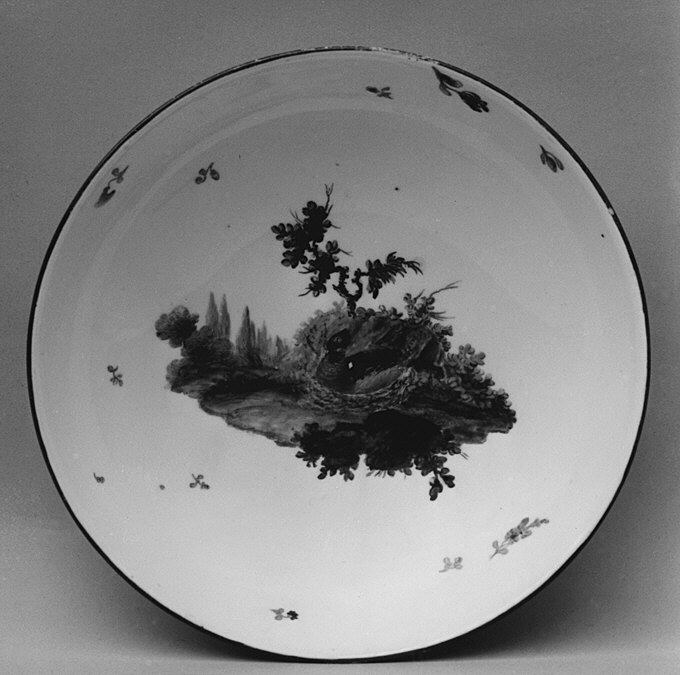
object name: saucer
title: Saucer (part of a service)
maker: frankenthal porcelain manufactory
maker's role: manufactory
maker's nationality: german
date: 1770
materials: hard paste porcelain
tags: trees